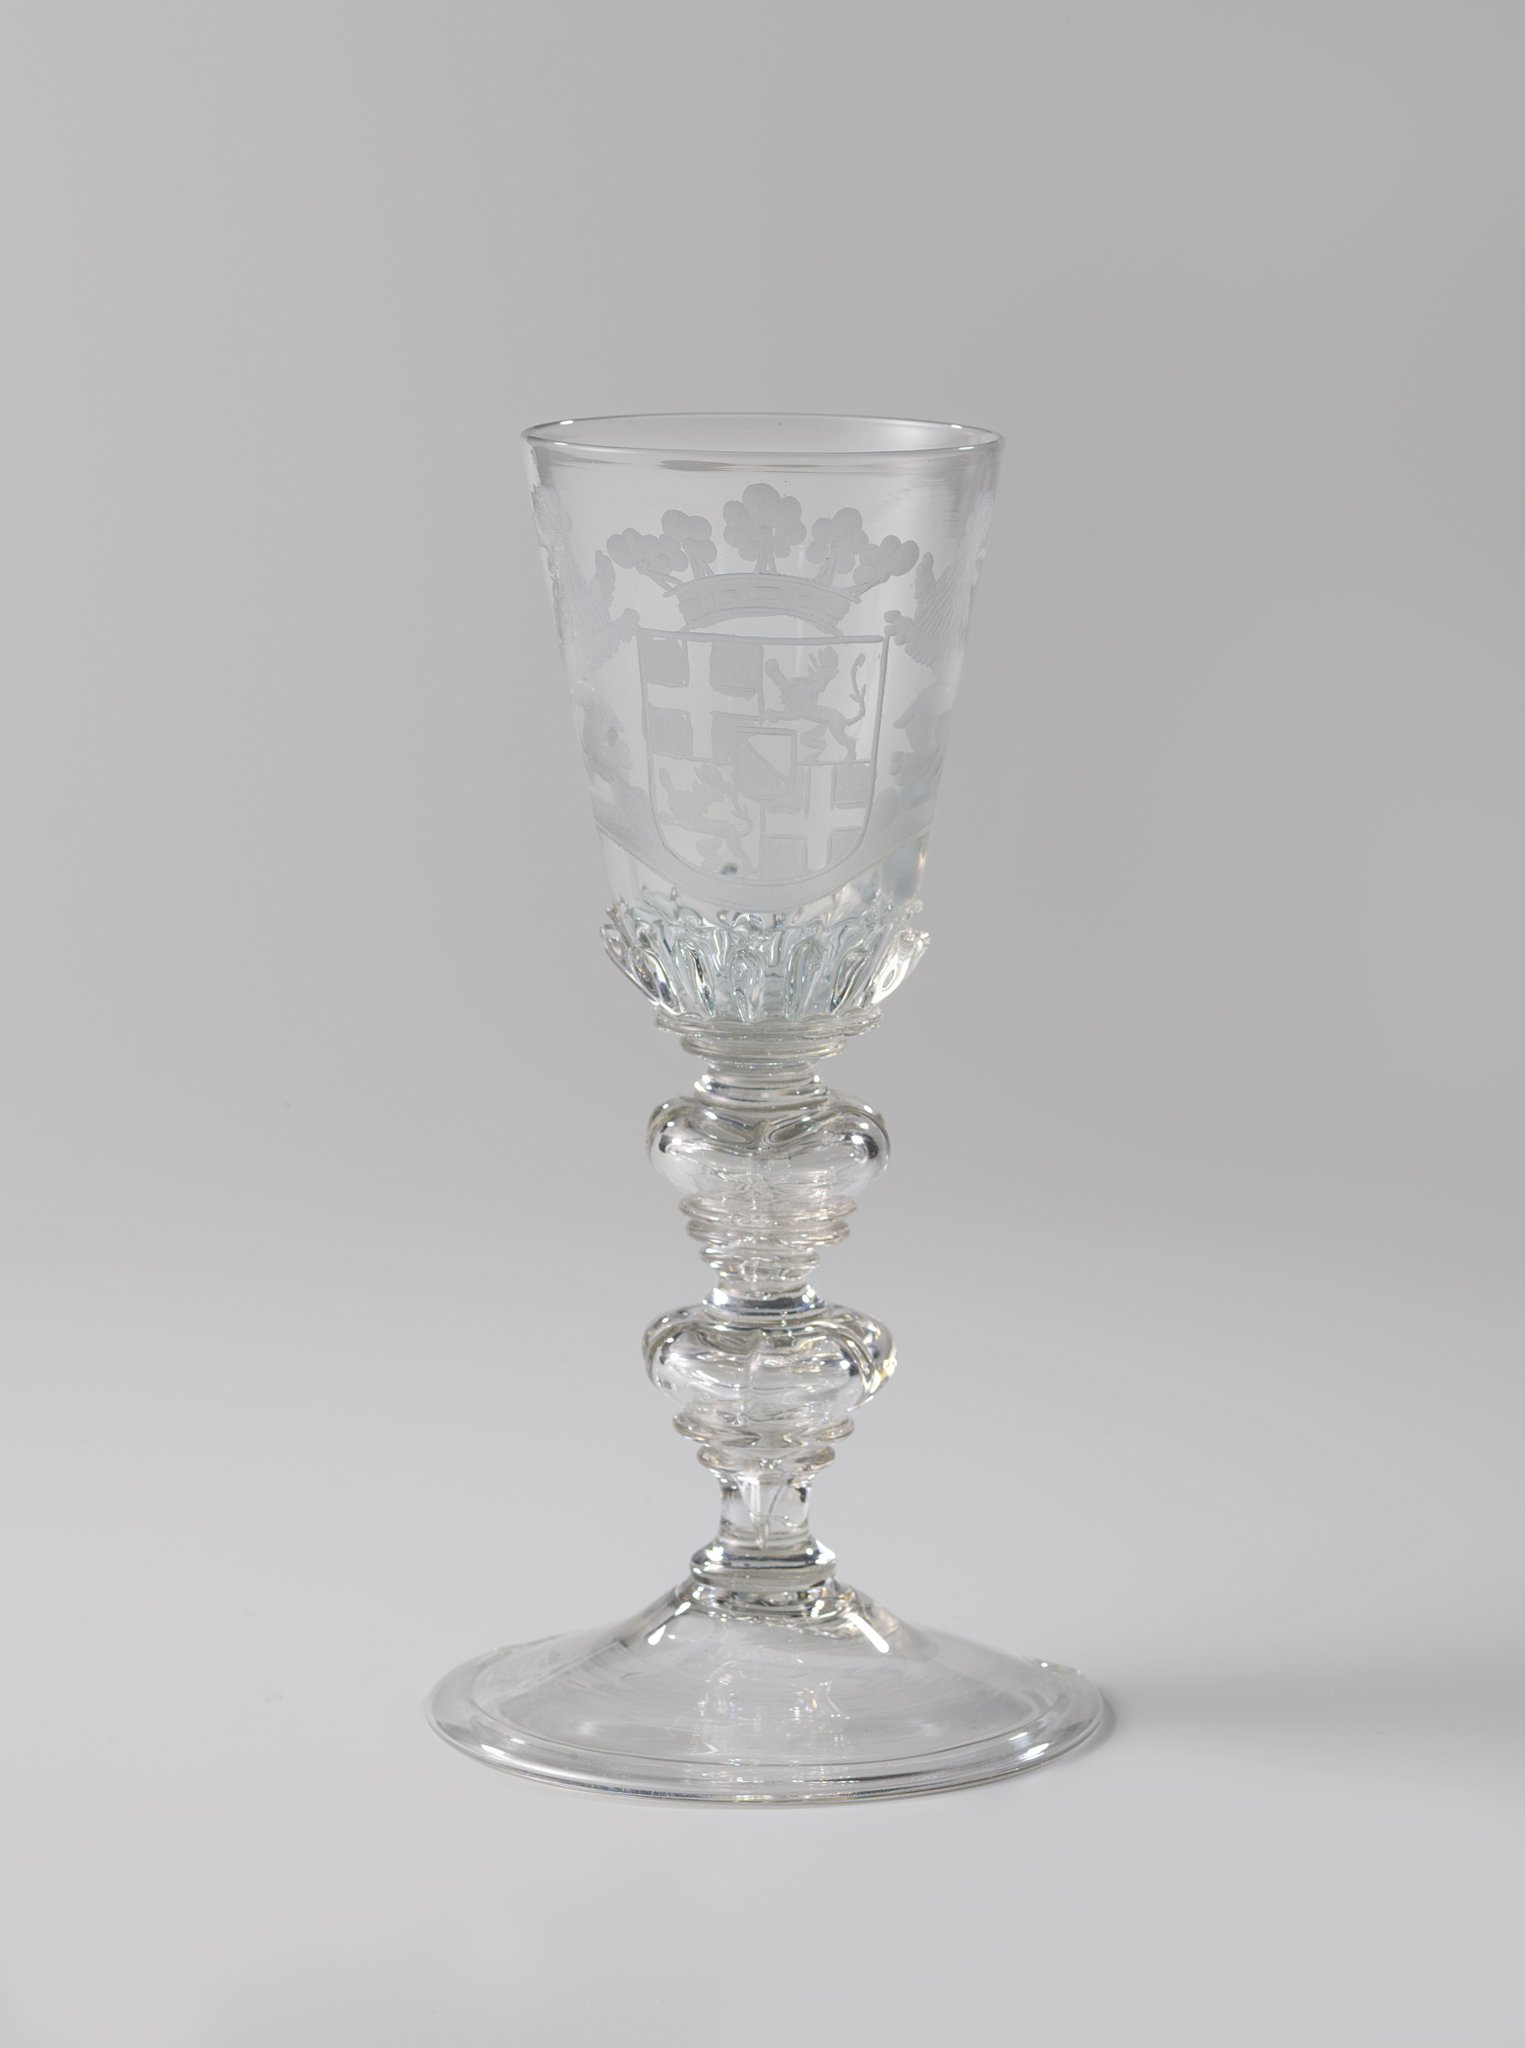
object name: goblet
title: Bokaal met het wapen van de provincie Utrecht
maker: Anonymous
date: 1680-1700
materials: glass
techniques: façon de venise, glassblowing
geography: northern netherlands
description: Gewelfde voet met omgeslagen rand. Stam met twee holle, vijflobbige knopen. Op de conische kelk het wapen van Utrecht en als hartschild het stadswapen. Deksel met gegraveerde rand.